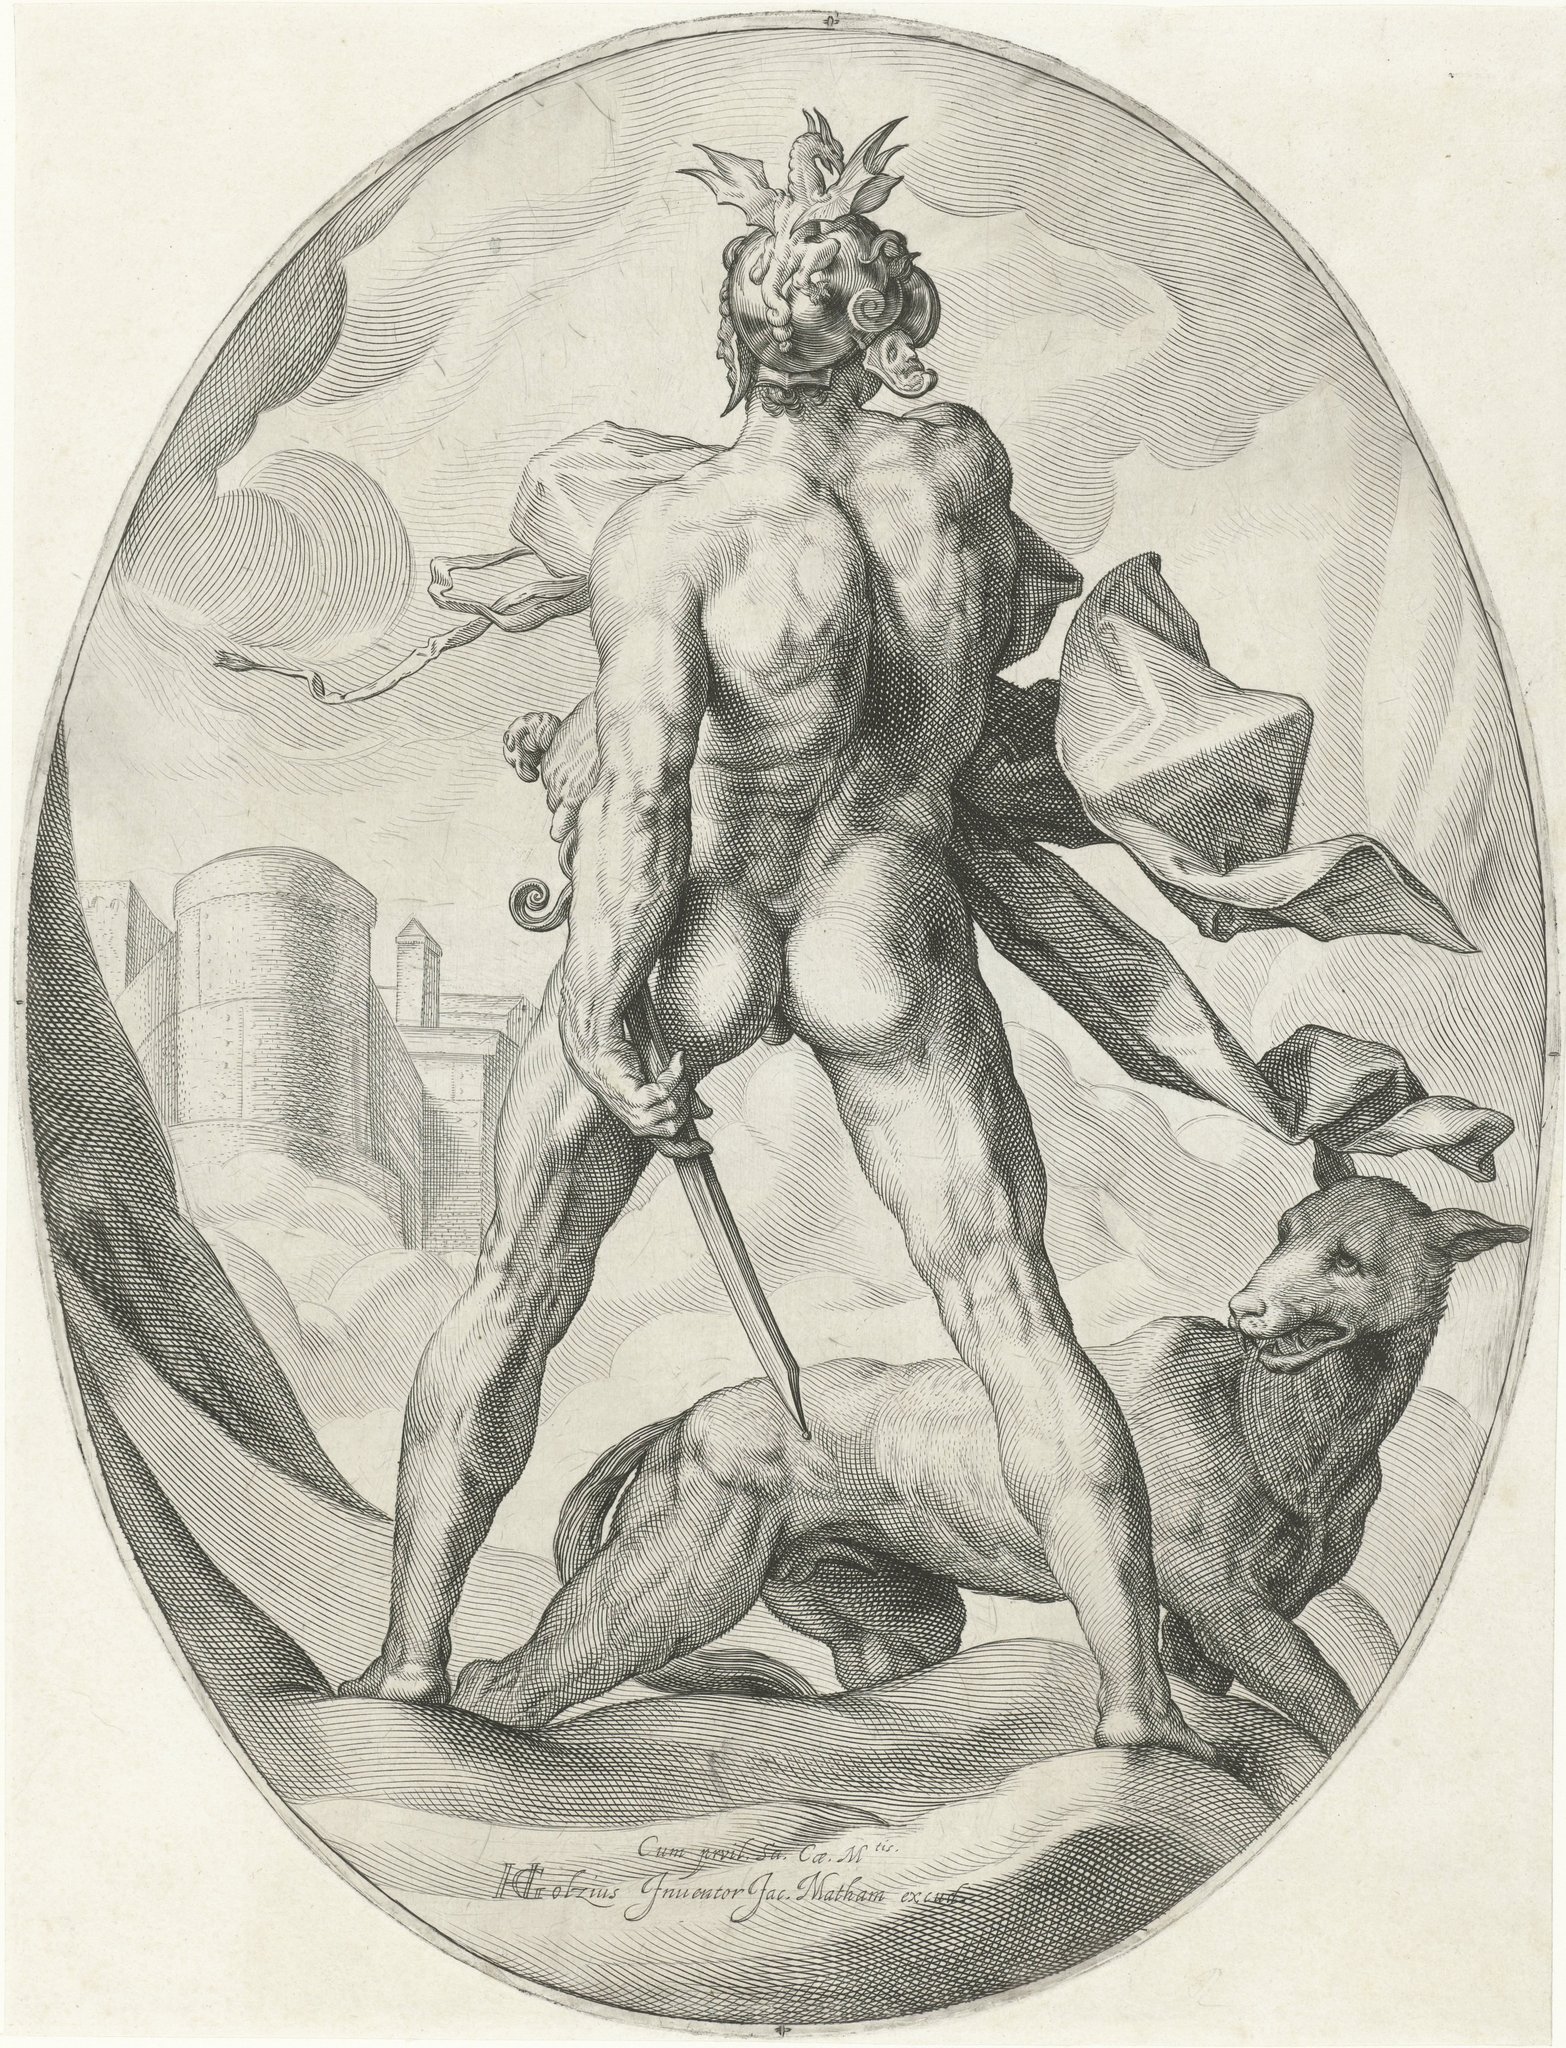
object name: print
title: Mars op de wolken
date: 1599-1603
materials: paper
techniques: engraving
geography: haarlem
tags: (story of) mars (ares)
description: Mars, staand en op de rug gezien, op de wolken, met zwaard en helm. Naast hem een hond.